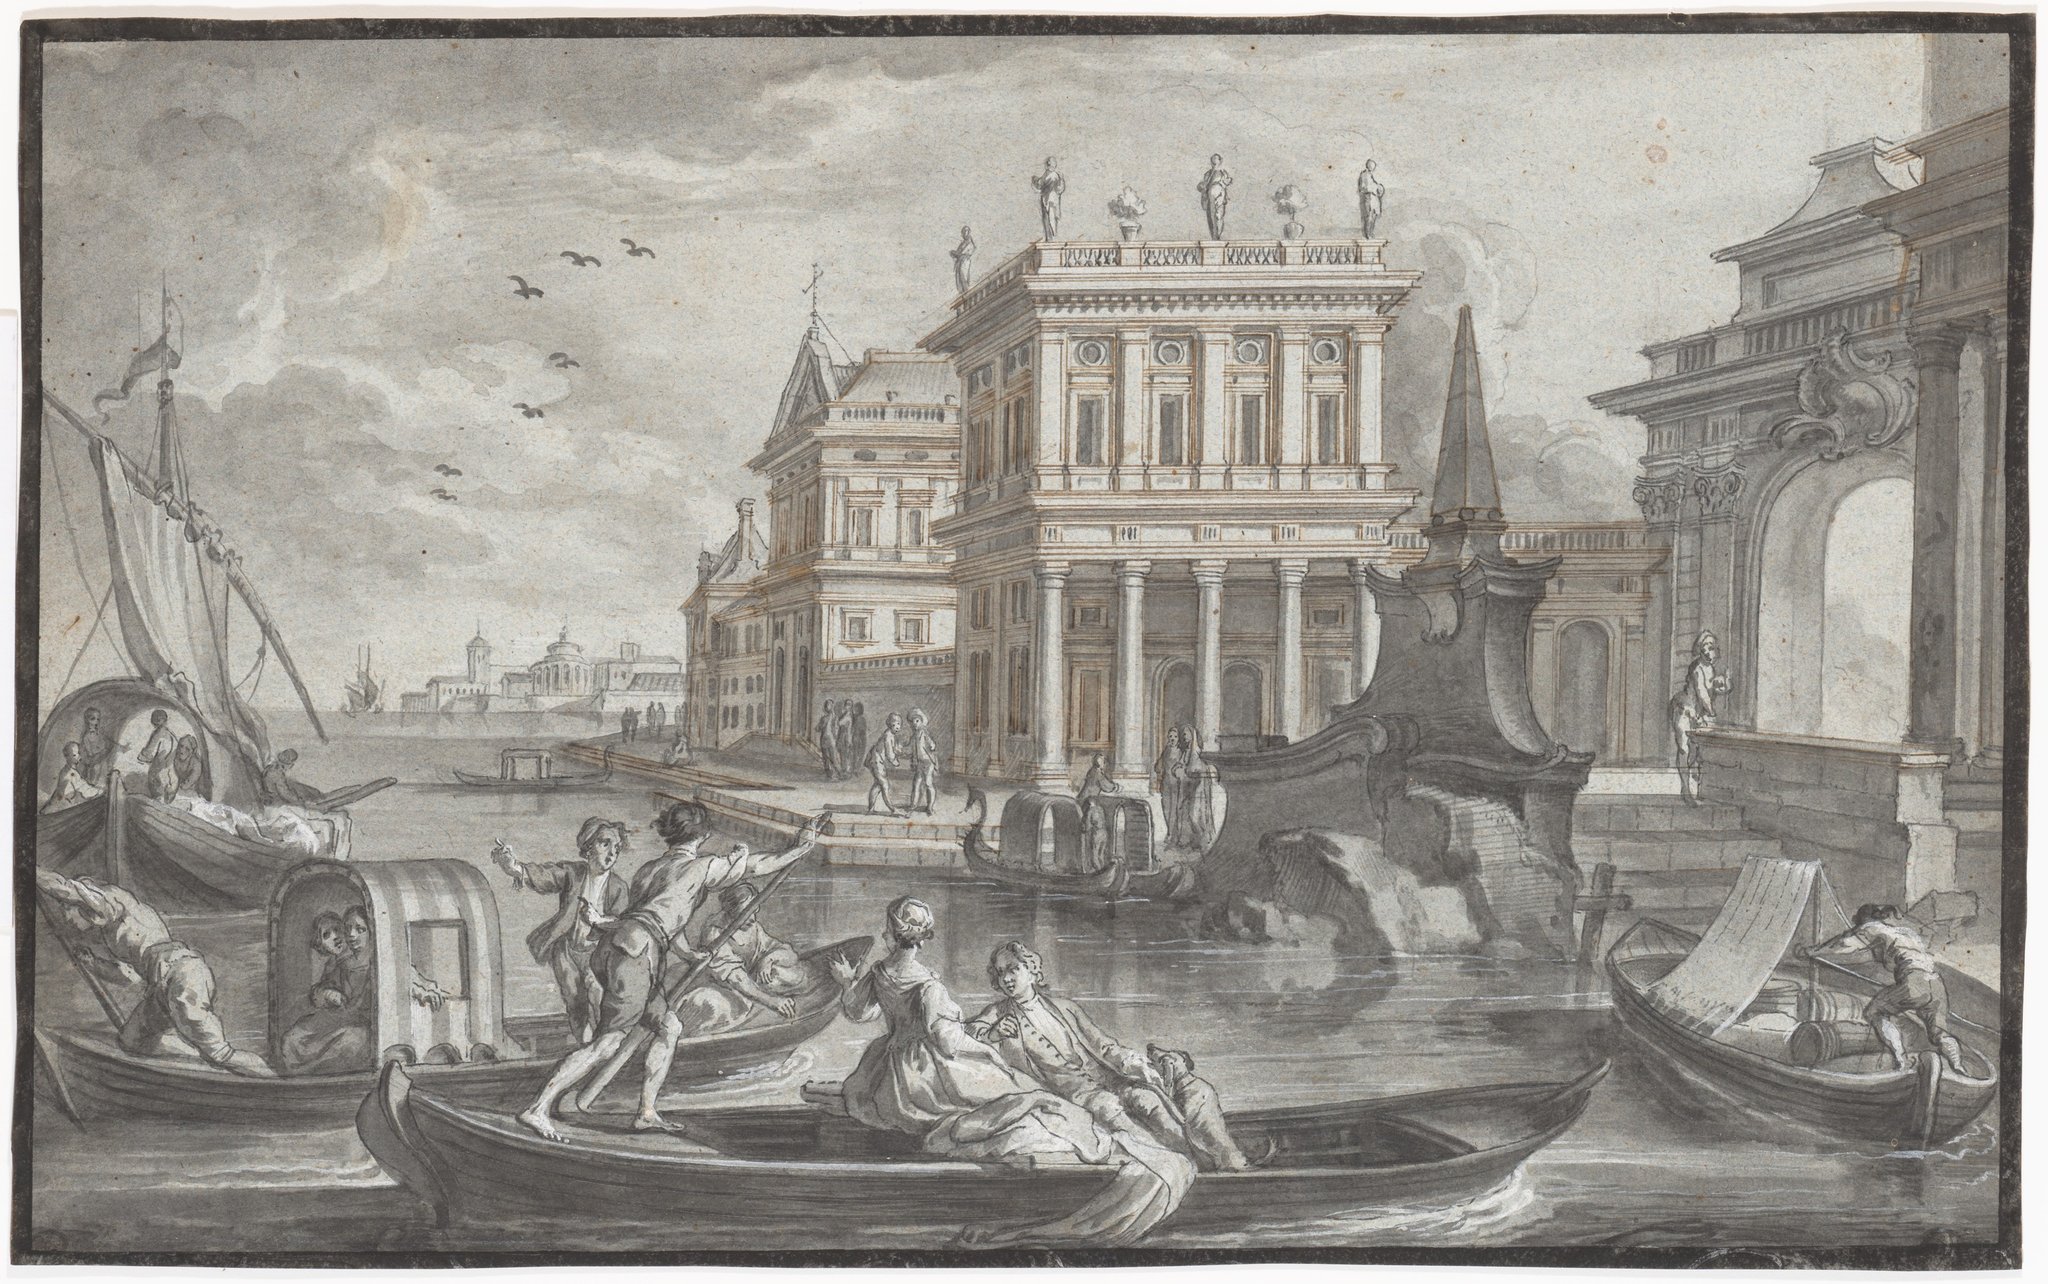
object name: drawing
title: Canal Scene with a Palazzo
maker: johann wolfgang baumgartner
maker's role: artist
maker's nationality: german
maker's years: 1712-1761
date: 1734-1766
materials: chalk, gouache, ink, paper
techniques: brush, incising, pen, transfer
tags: buildings,men,women,canals,boats